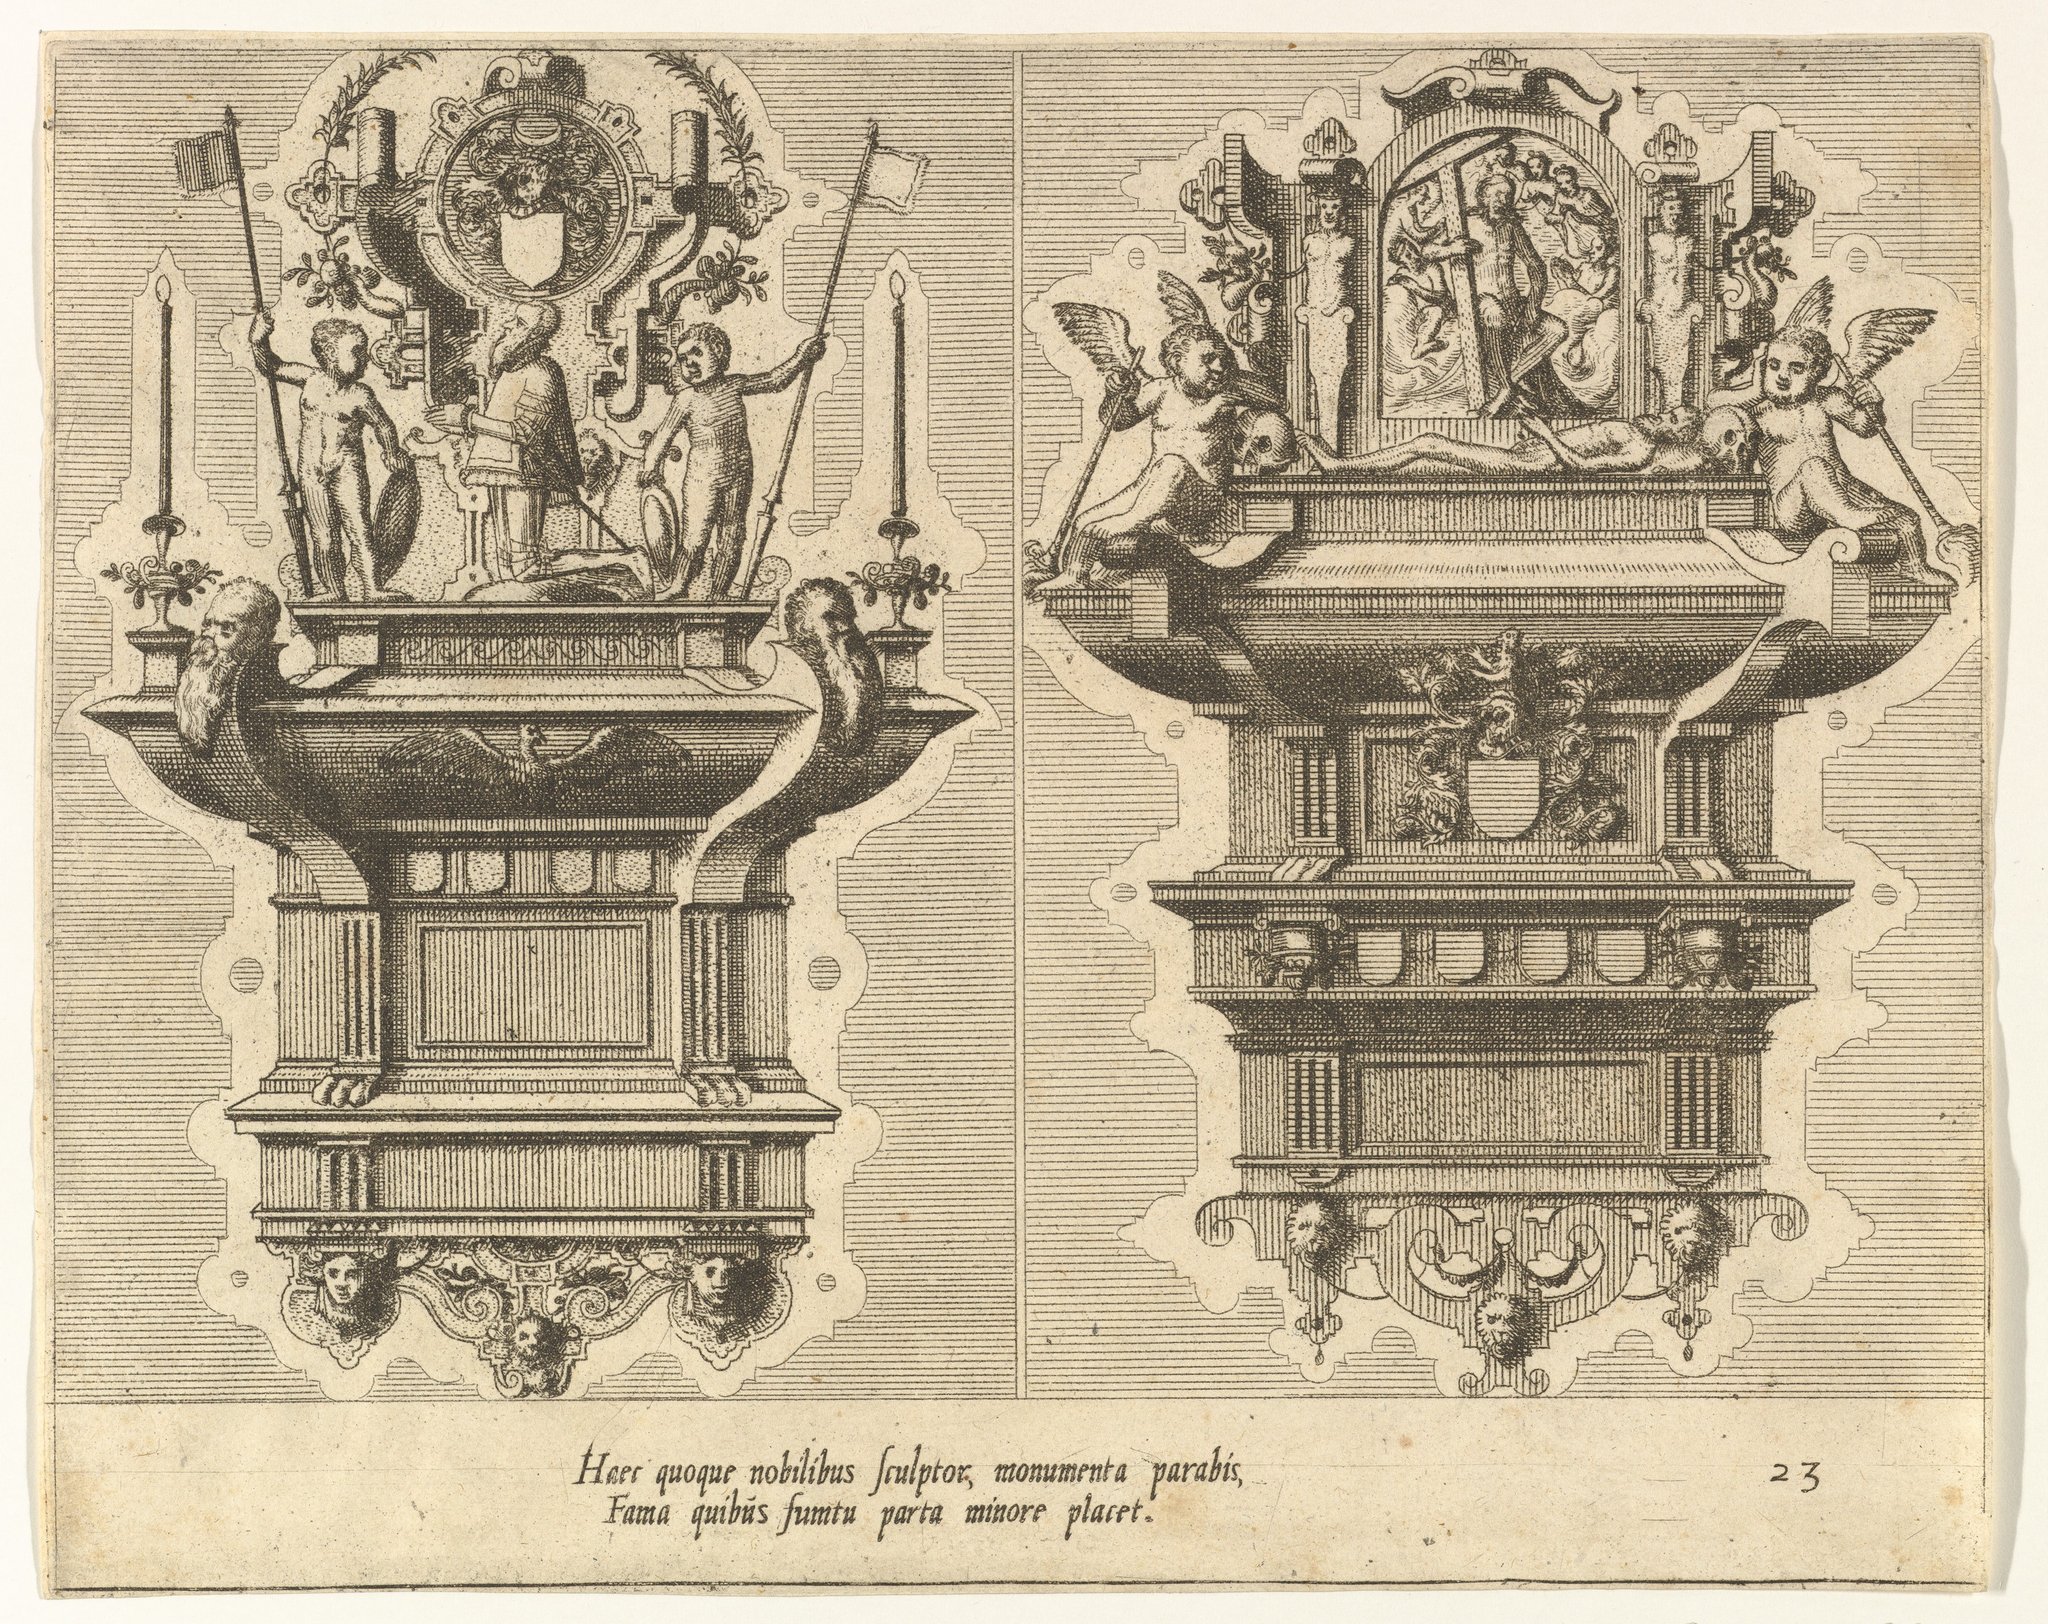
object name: collection ornament architecture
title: Cœnotaphiorum (23)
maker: hans vredeman de vries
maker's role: artist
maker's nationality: netherlandish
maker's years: 1527-1606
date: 1563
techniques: etching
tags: architecture,tombs,men,women,putti